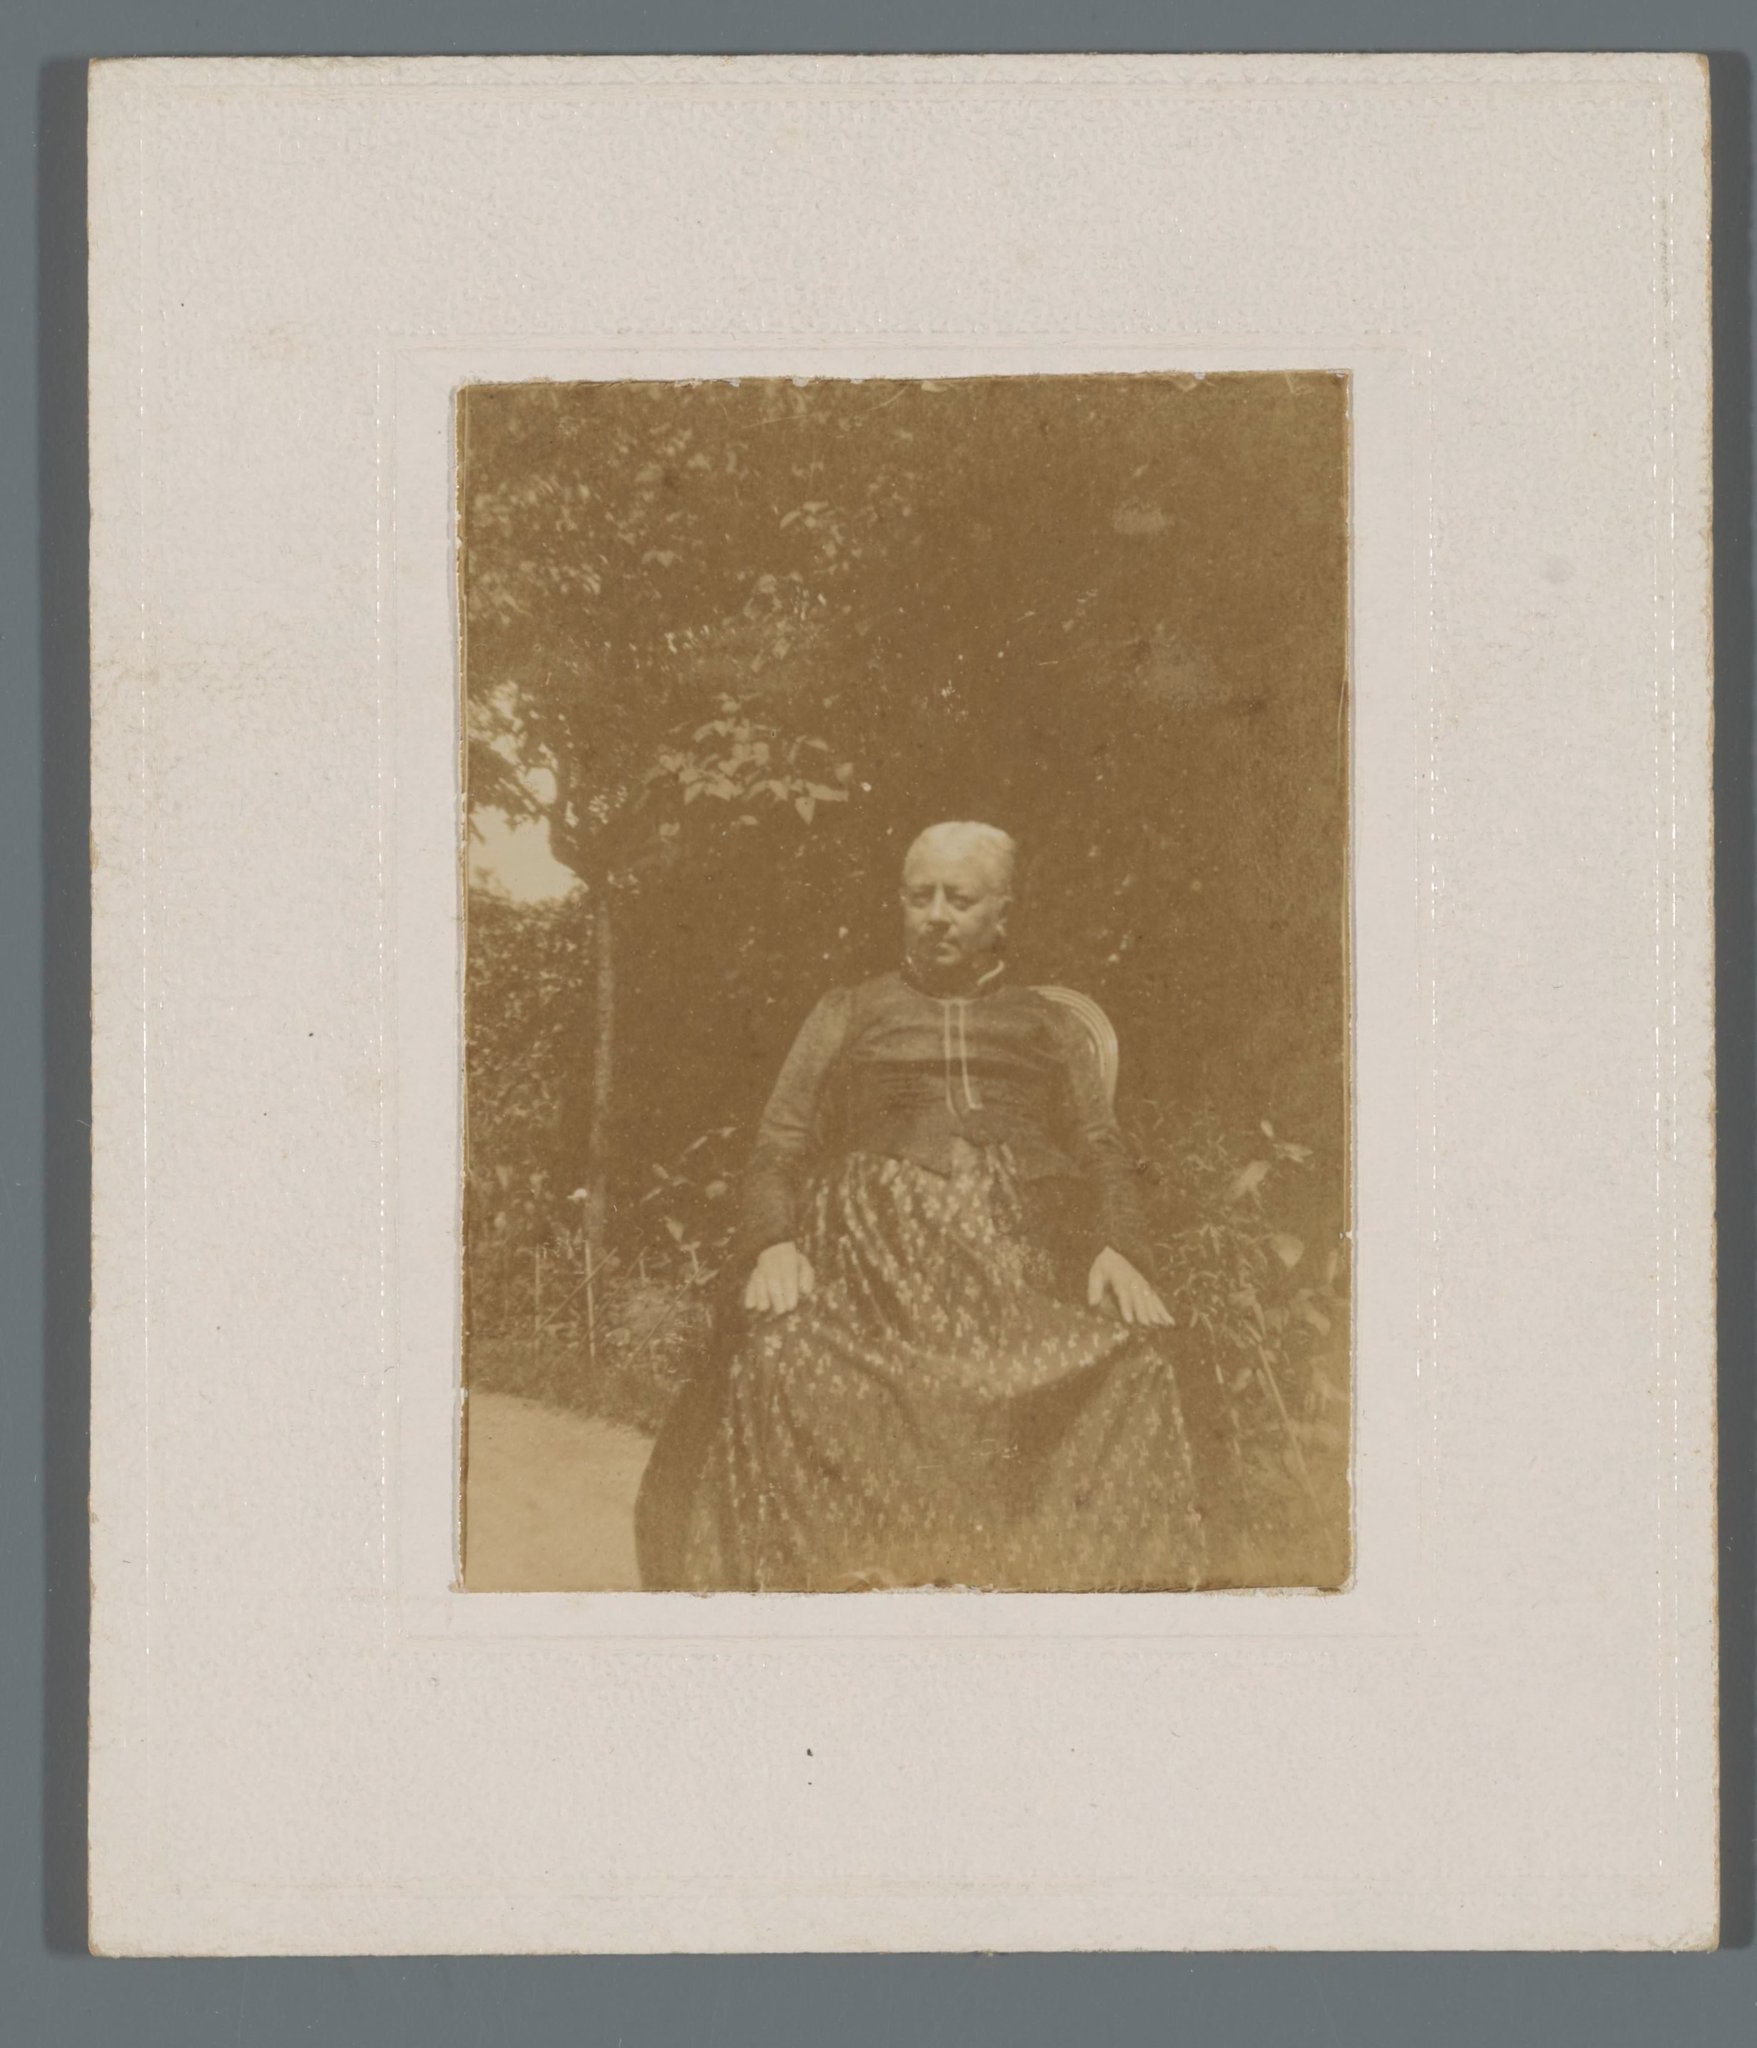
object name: photograph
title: Portret van een onbekende vrouw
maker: cornelia hendrika jonker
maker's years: 1874-1924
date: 1880-1940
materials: cardboard, photographic support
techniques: collodion silver print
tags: historical persons - bb - woman